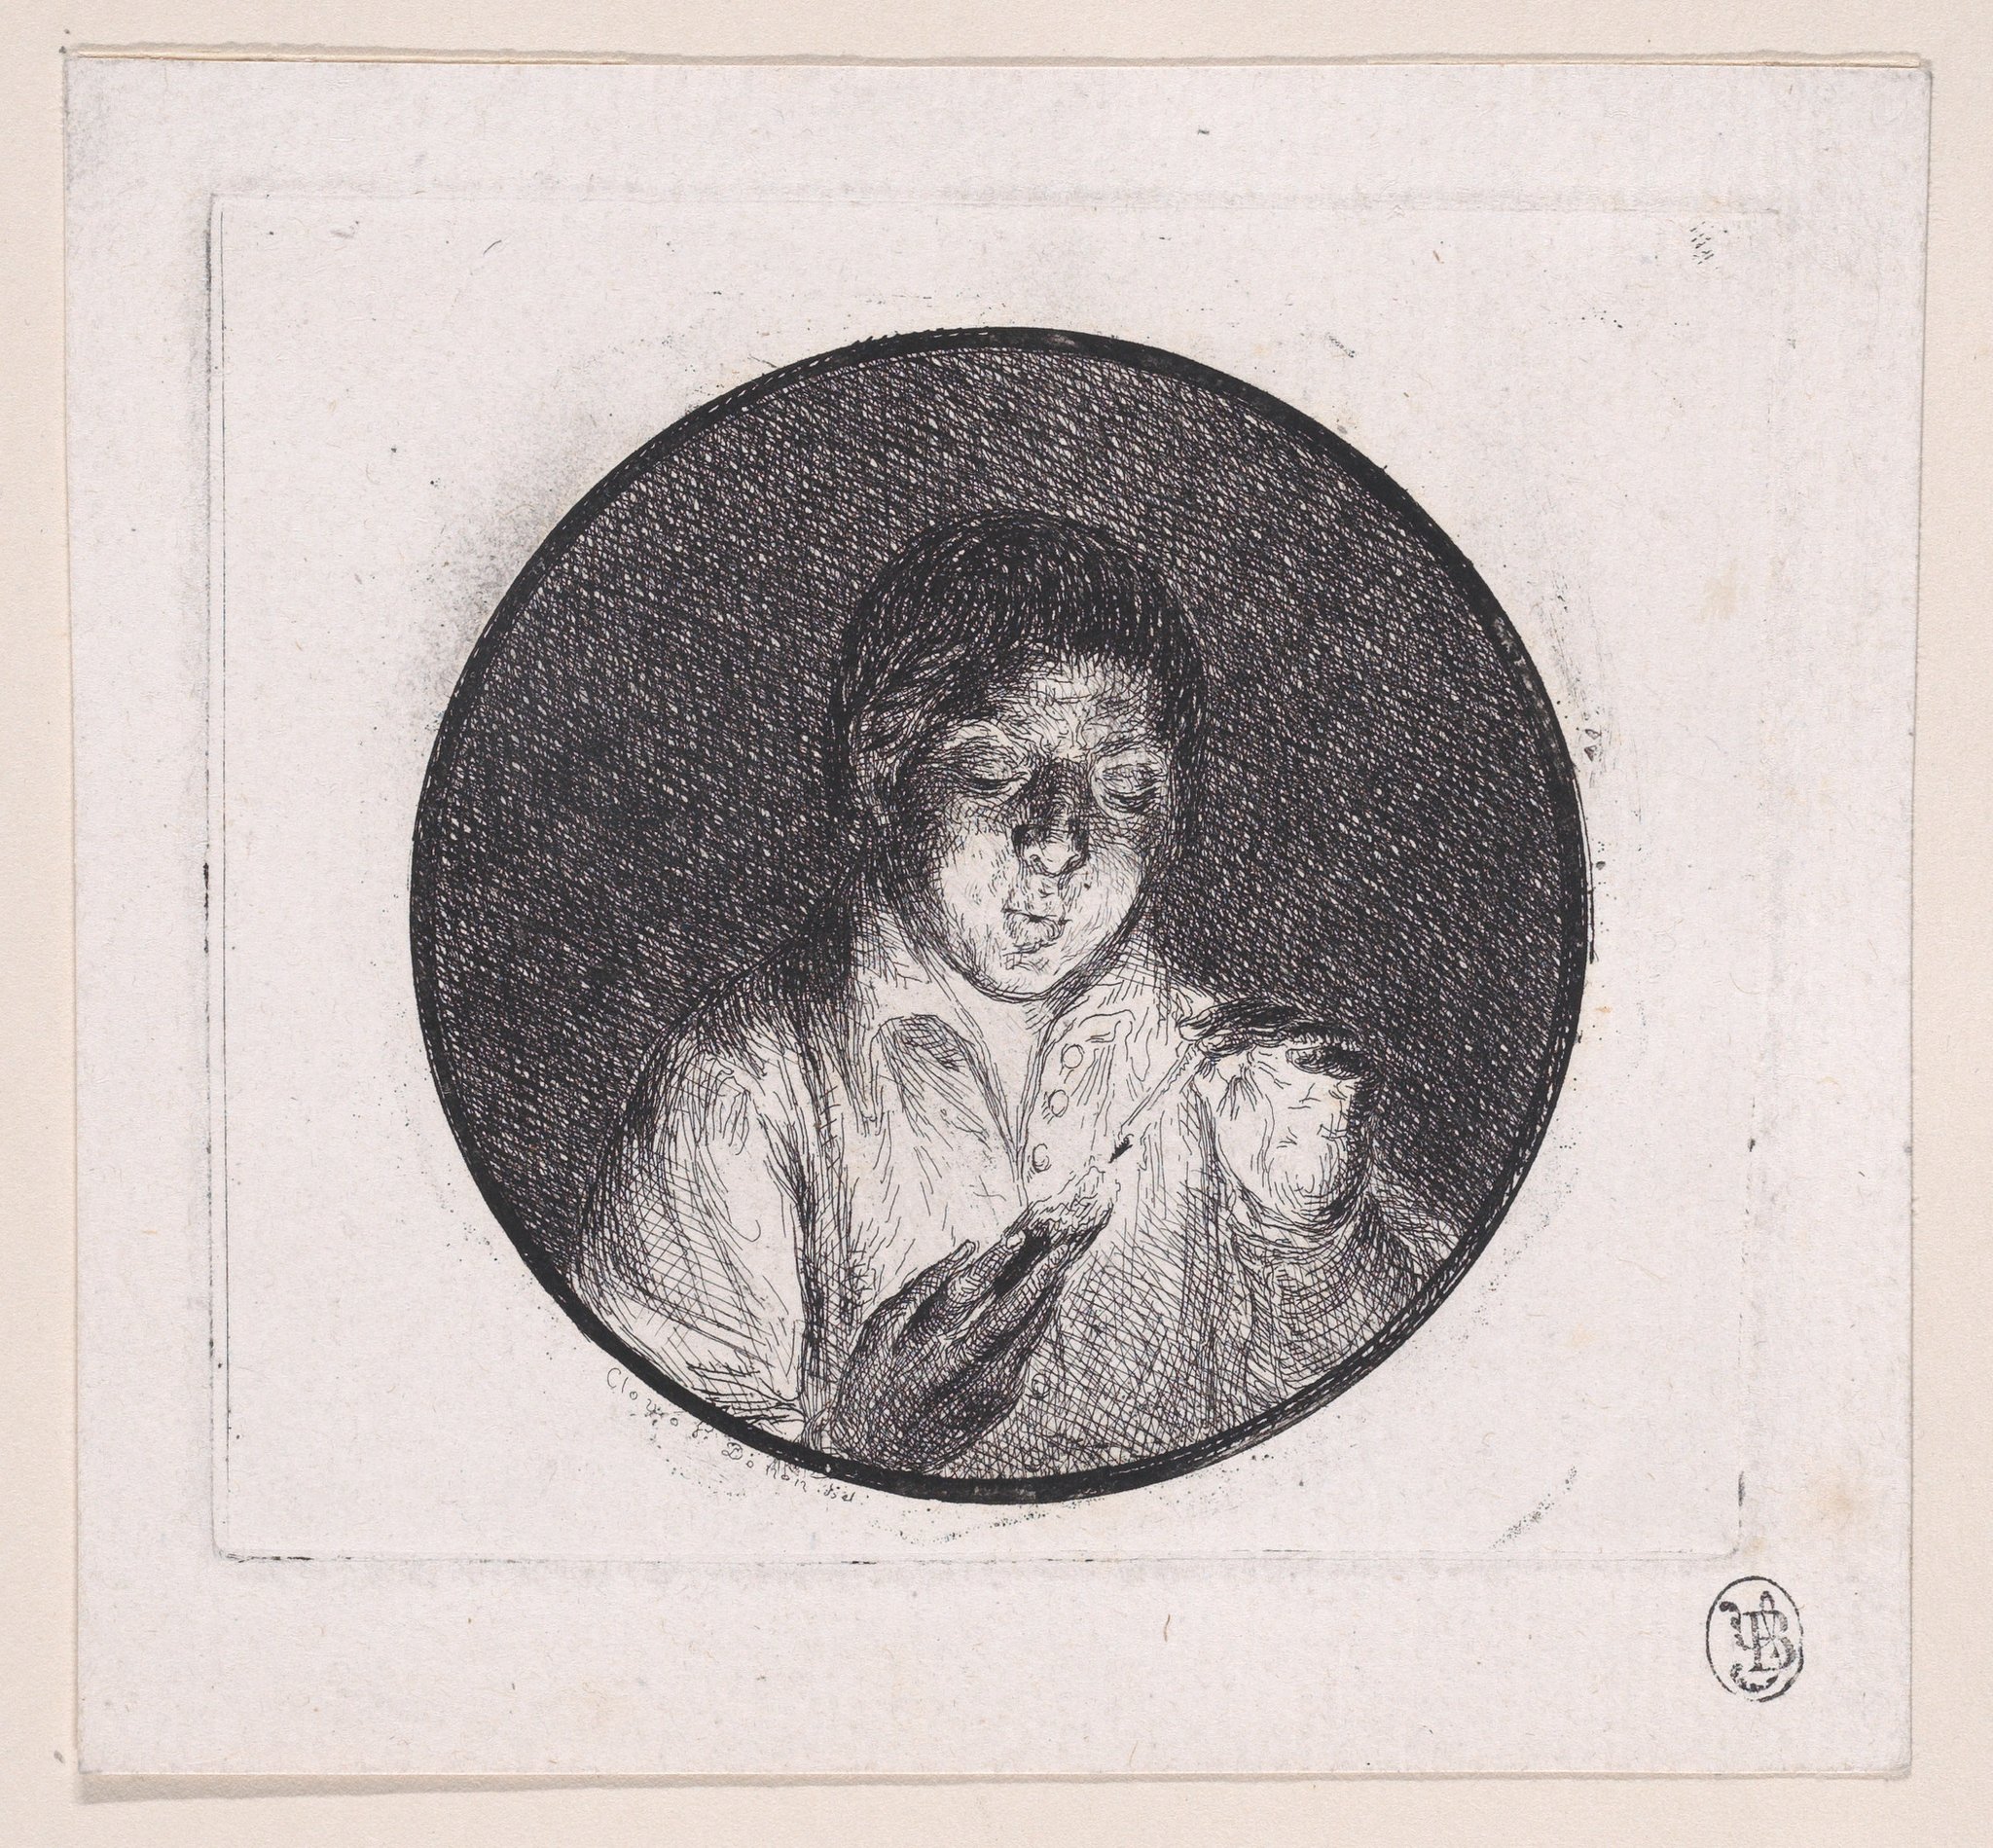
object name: print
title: Bust of a Man Lighting a Match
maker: baron dominique vivant denon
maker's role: artist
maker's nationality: french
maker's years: 1747-1825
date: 1701-1833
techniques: etching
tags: men